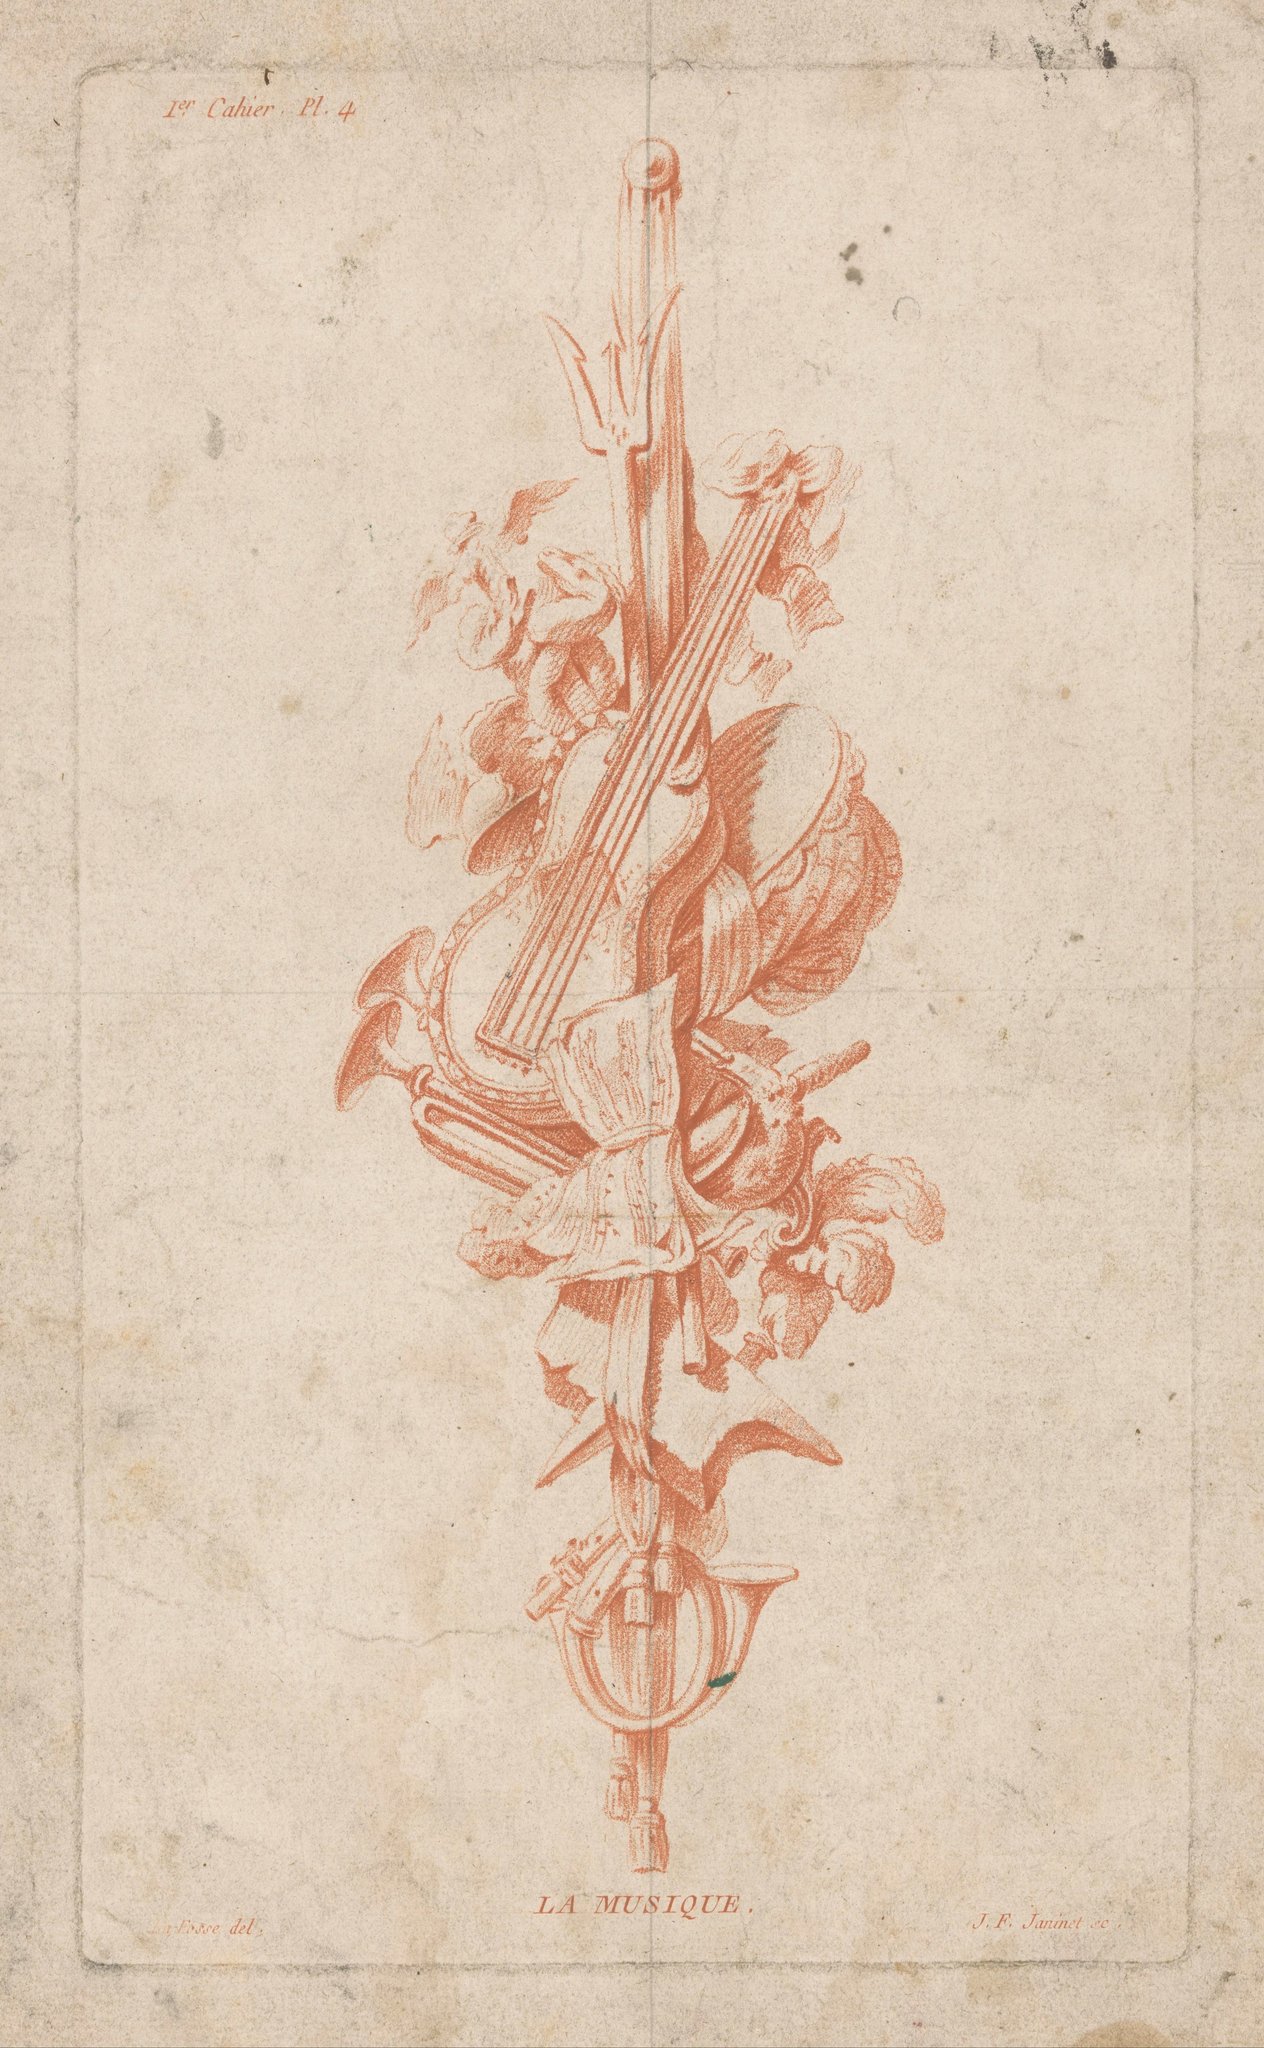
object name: print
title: Trofeeën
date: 1772-1779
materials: paper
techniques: printmaking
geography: paris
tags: musical instruments; group of musical instruments, trophy, i.e.: decorative arrangement of symbolic or typical objects ~ ornament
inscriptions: collector's mark: Lugt 2760, collector's mark: Lugt 2228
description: Een trofee met een drietand, een caduceus, een gitaar, trompetten en een hoorn.